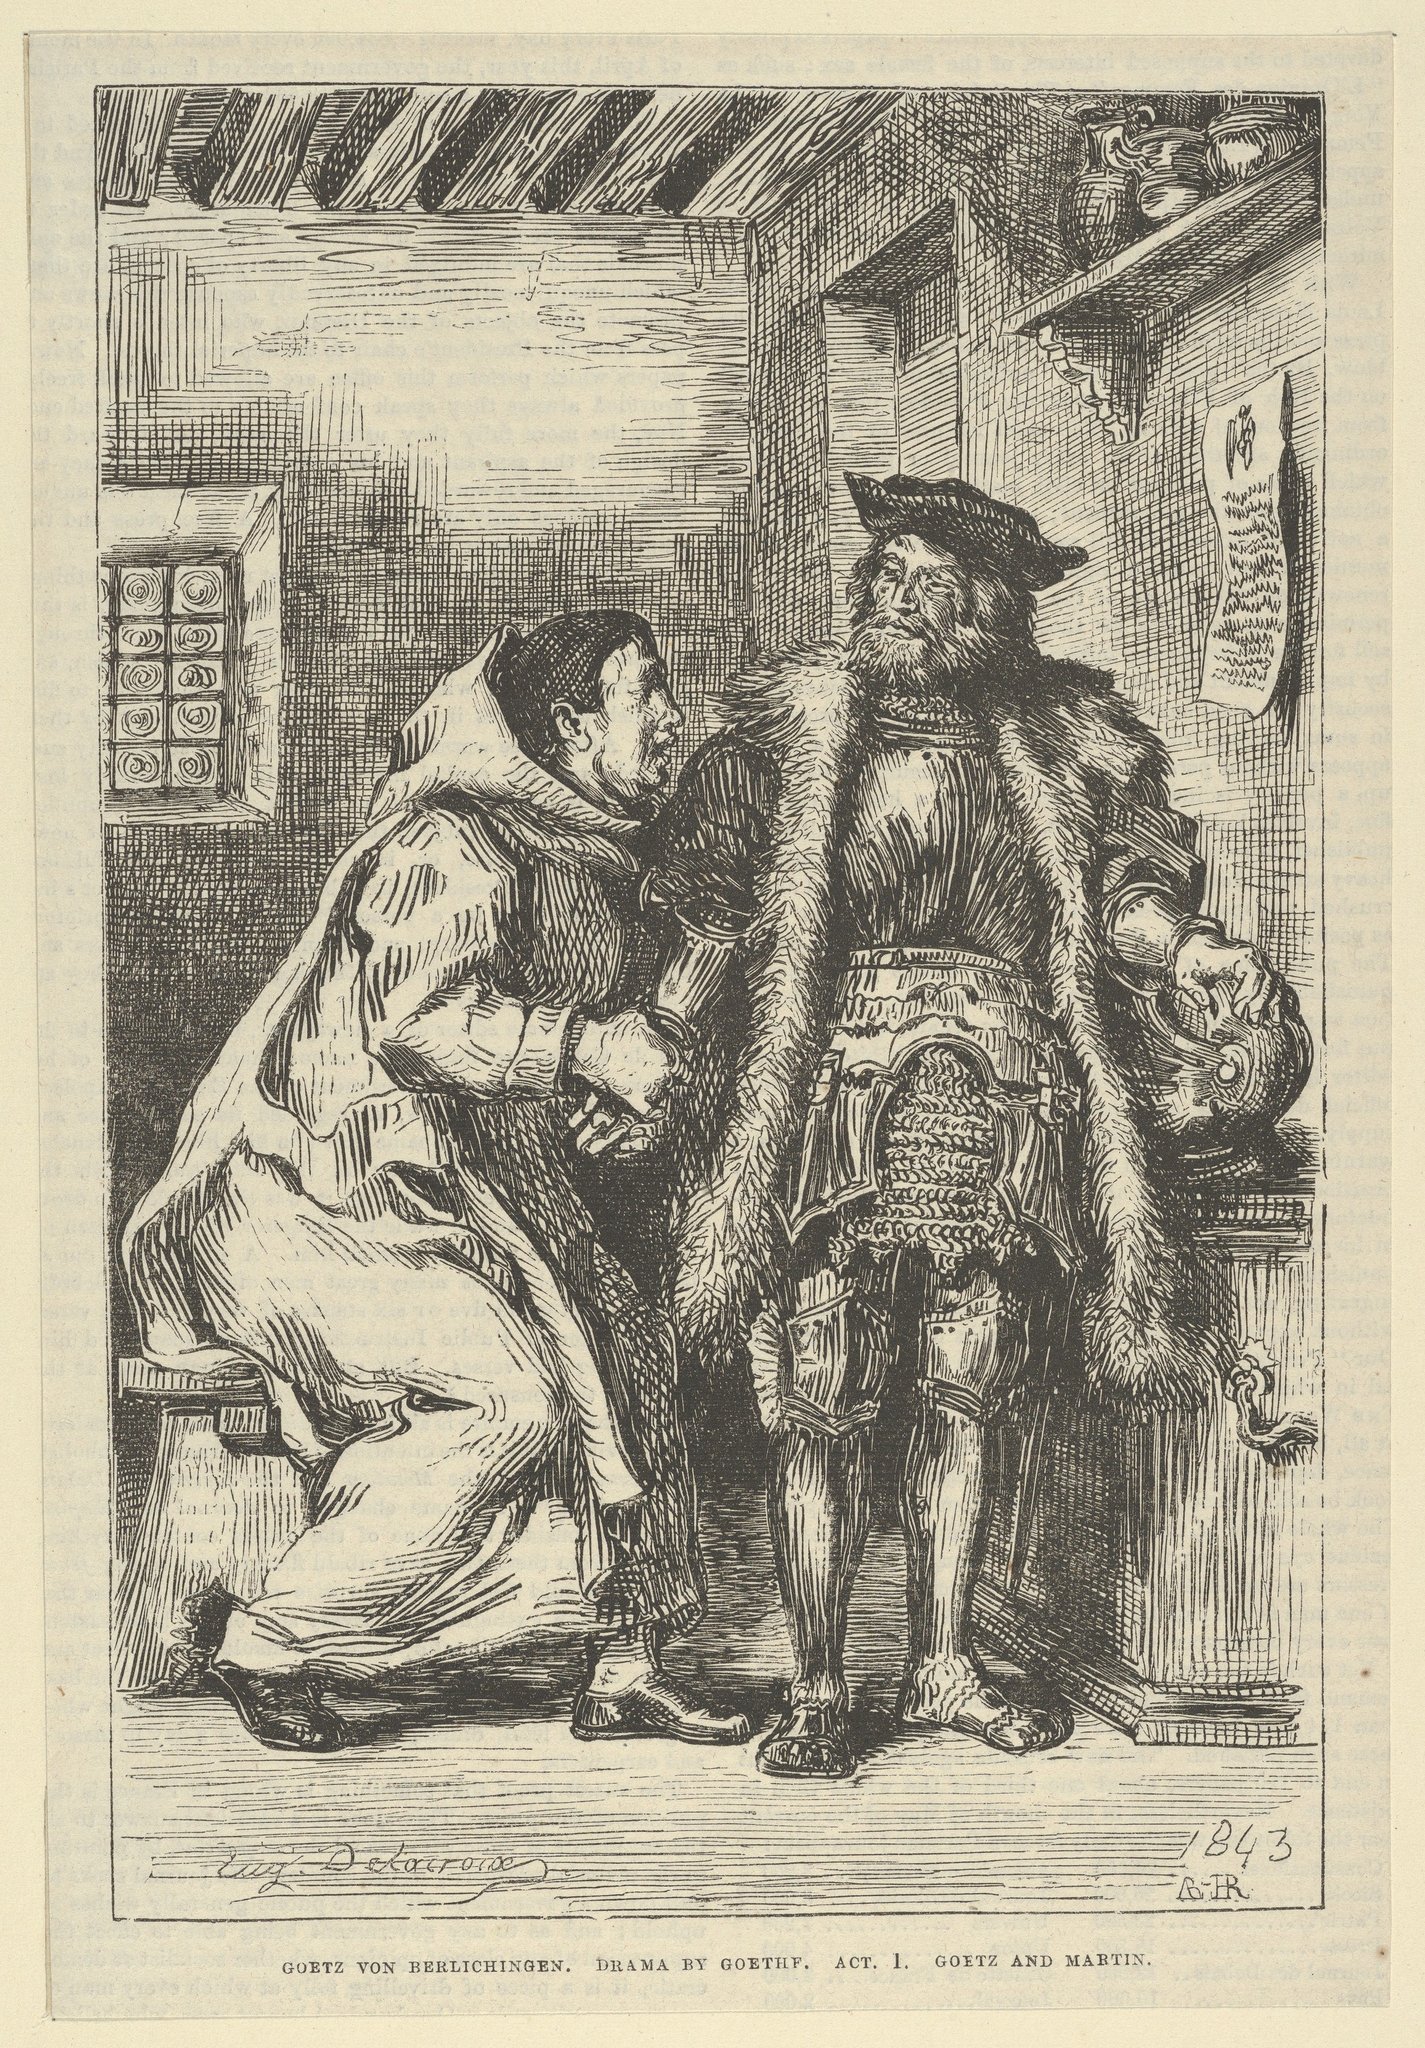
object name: print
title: Goetz and Friar Martin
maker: eugène delacroix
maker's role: artist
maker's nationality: french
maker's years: 1798-1863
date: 1845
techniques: engraving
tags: men